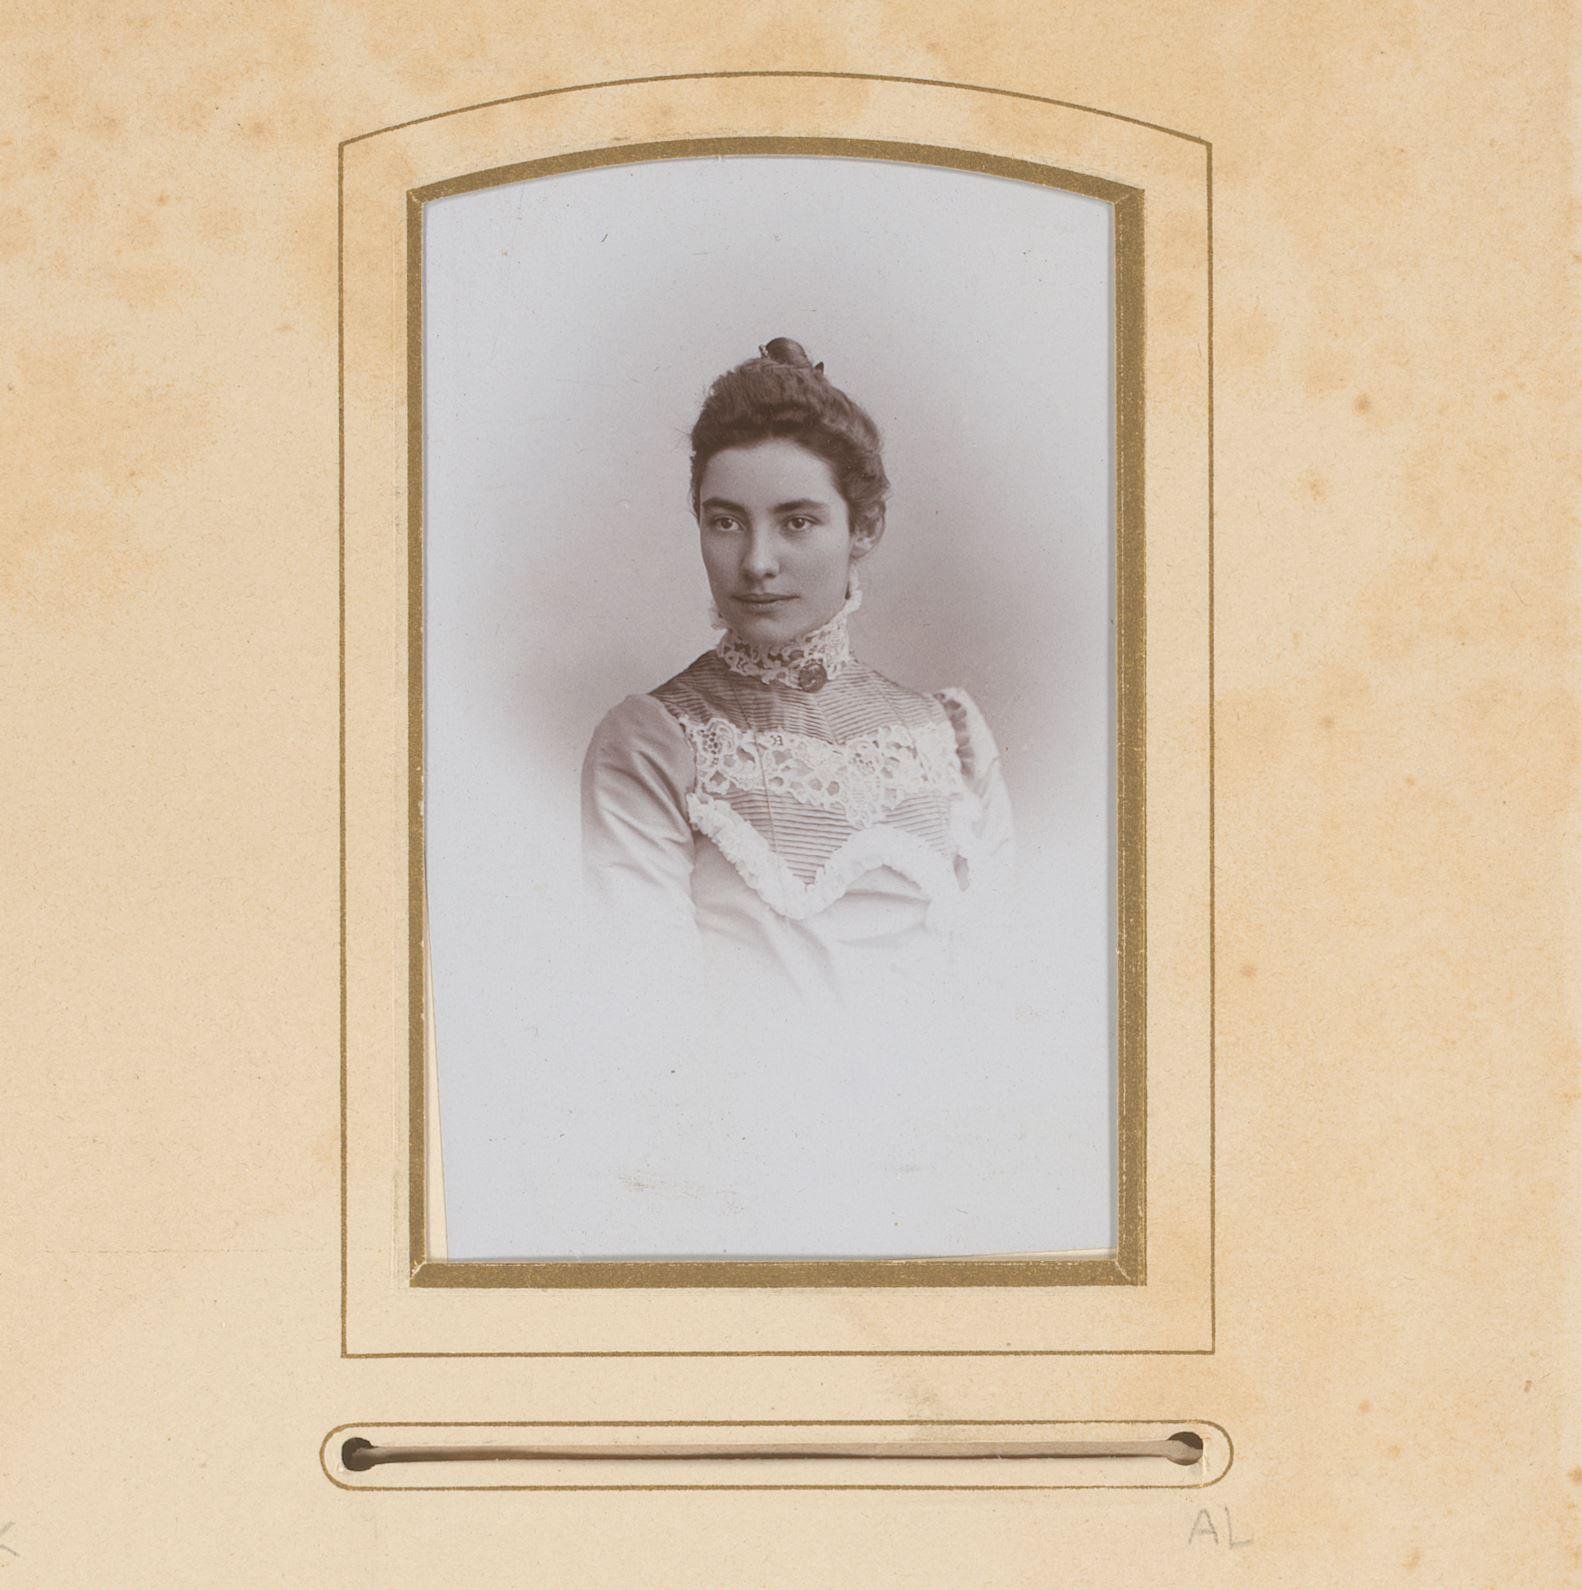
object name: carte de visite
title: Portret van een jonge vrouw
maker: emil flasche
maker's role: fotograaf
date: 1880-1920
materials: cardboard, photographic support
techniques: collodion silver print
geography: barmen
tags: adolescent, young woman, maiden, historical persons - bb - woman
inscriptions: inscription: ‘Emil Flasche/ Barmen/ Heckinghauser-Str. 19./ FERNSPRECHER 505.’